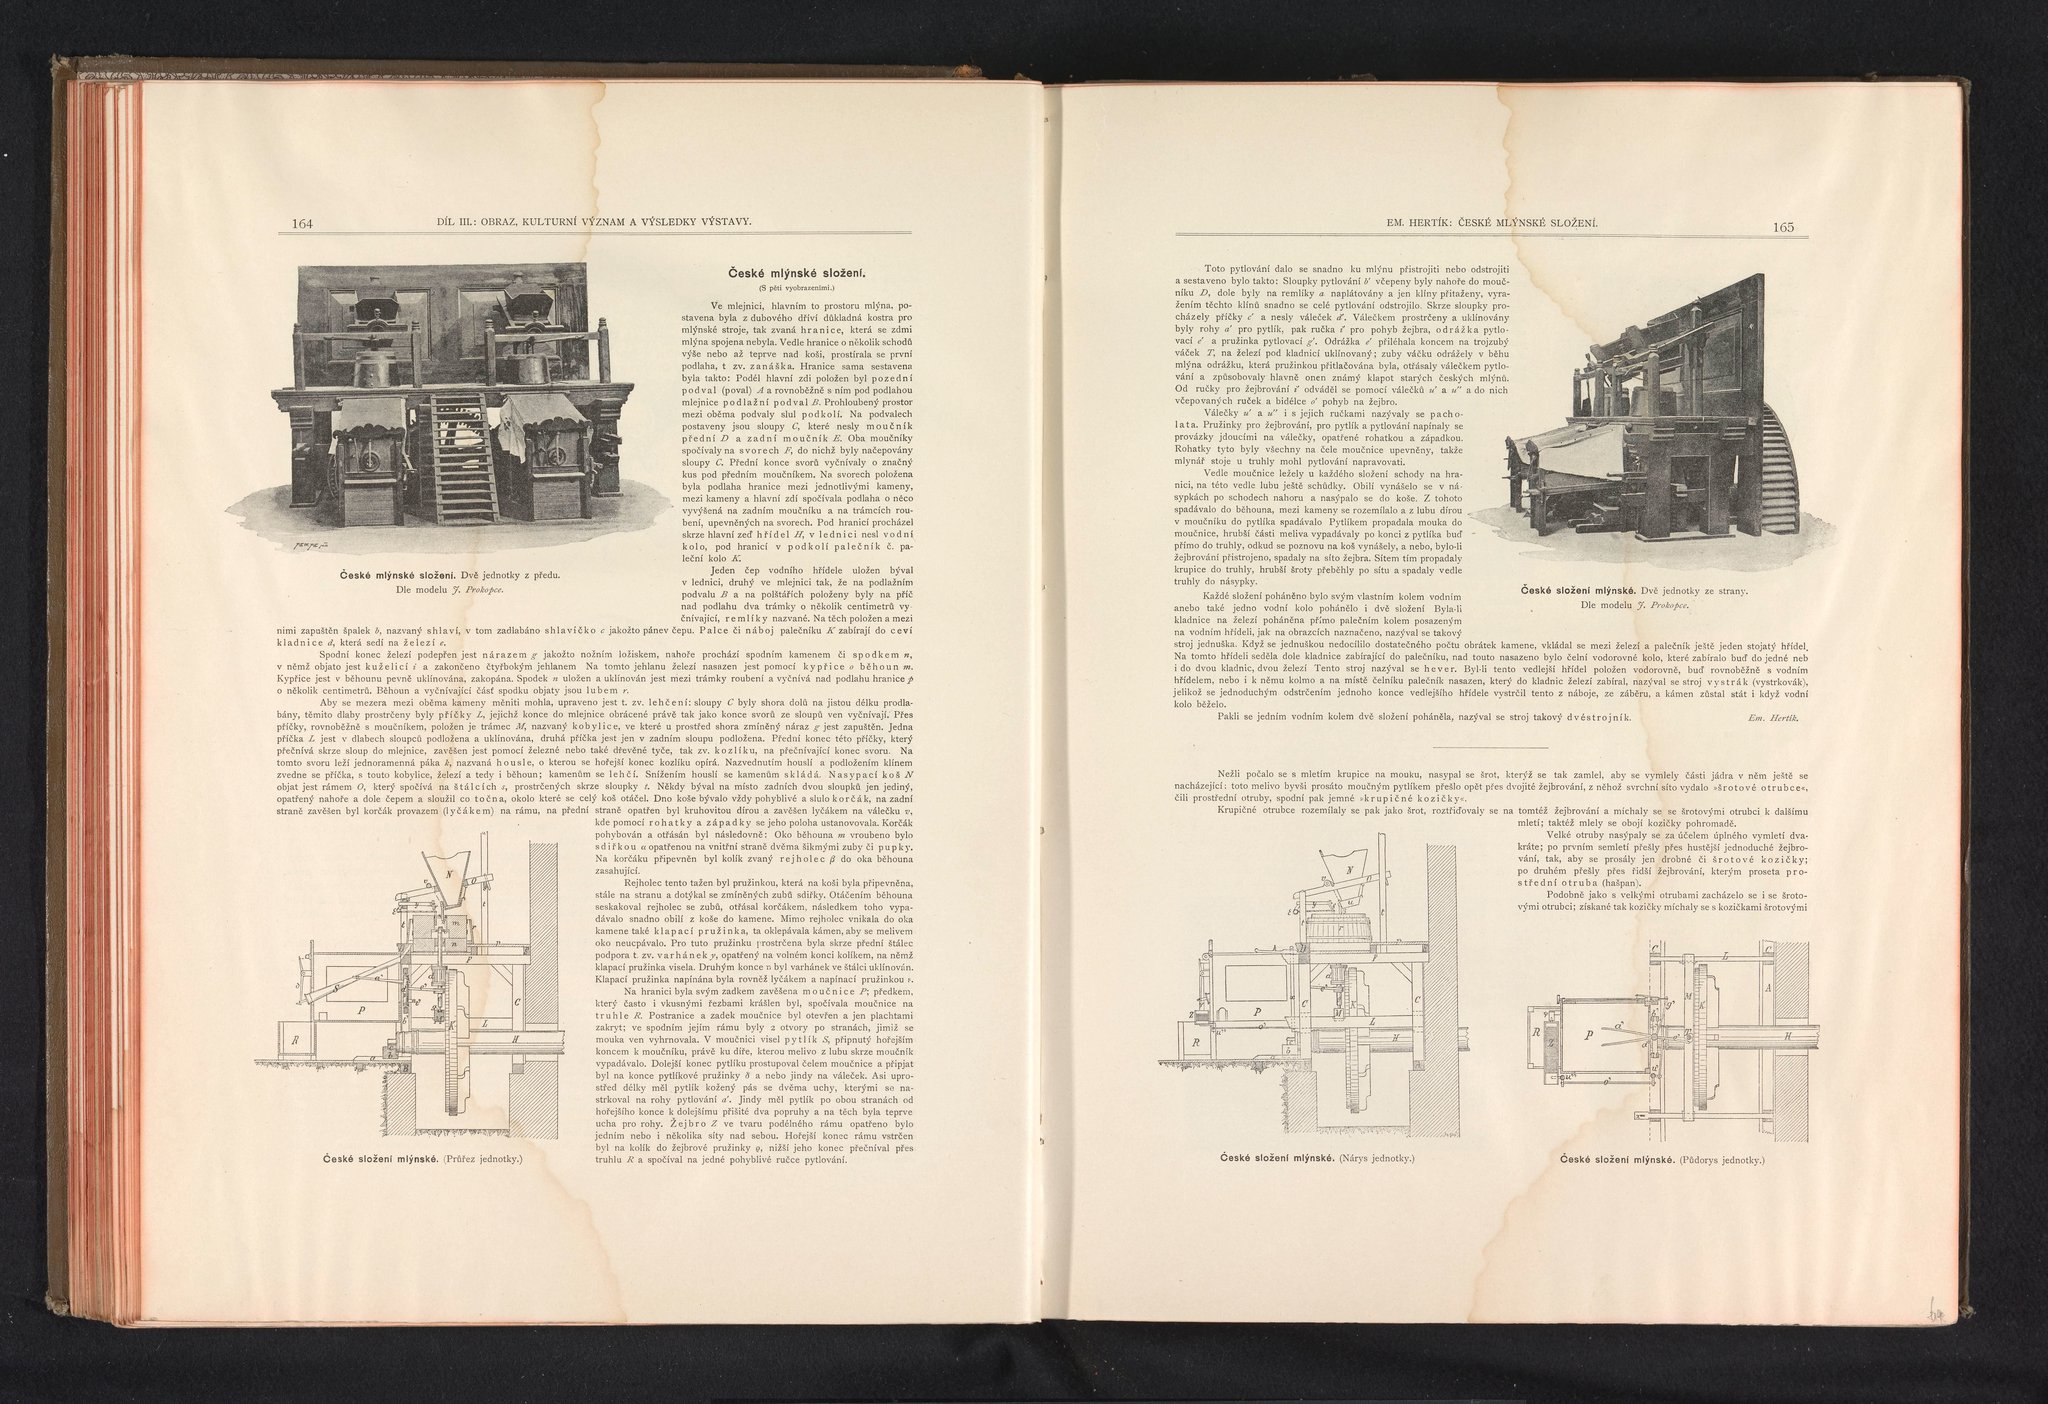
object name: photomechanical print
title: Ceské slozeni mlýnské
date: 1890-1895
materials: paper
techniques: autotype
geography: prague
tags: grinding, milling (industrial processes)